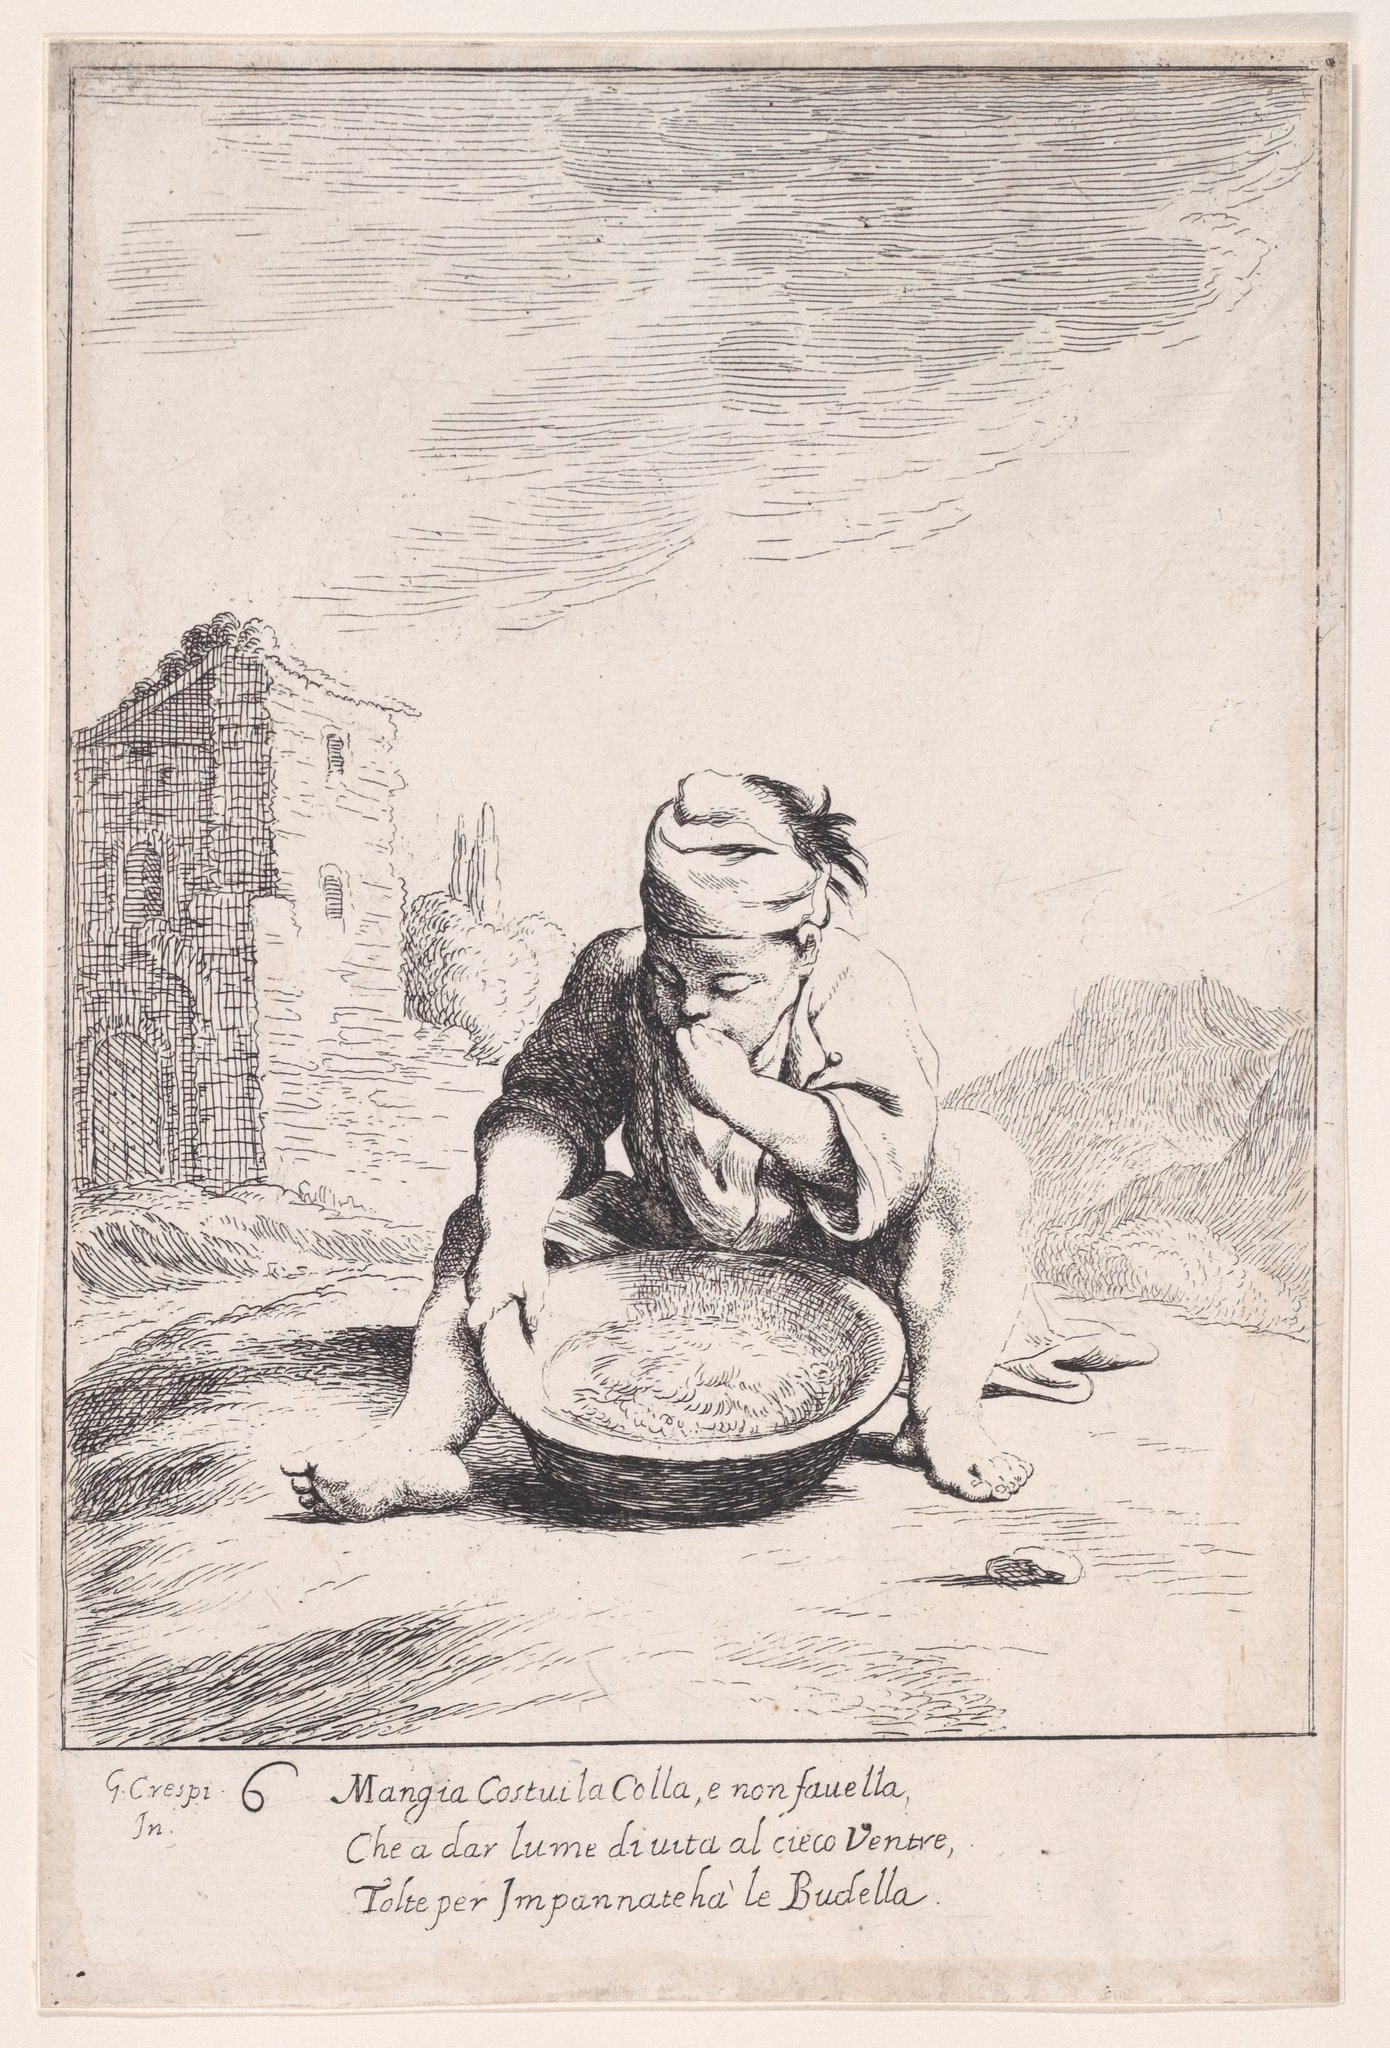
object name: print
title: Plate 20: Cacasenno eating a bowl of pasta, from "Bertoldo, Bertoldino, and Cacasenno"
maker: giuseppe maria crespi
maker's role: artist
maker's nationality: italian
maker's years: 1665-1747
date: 1705-1715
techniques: etching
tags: food,boys,eating